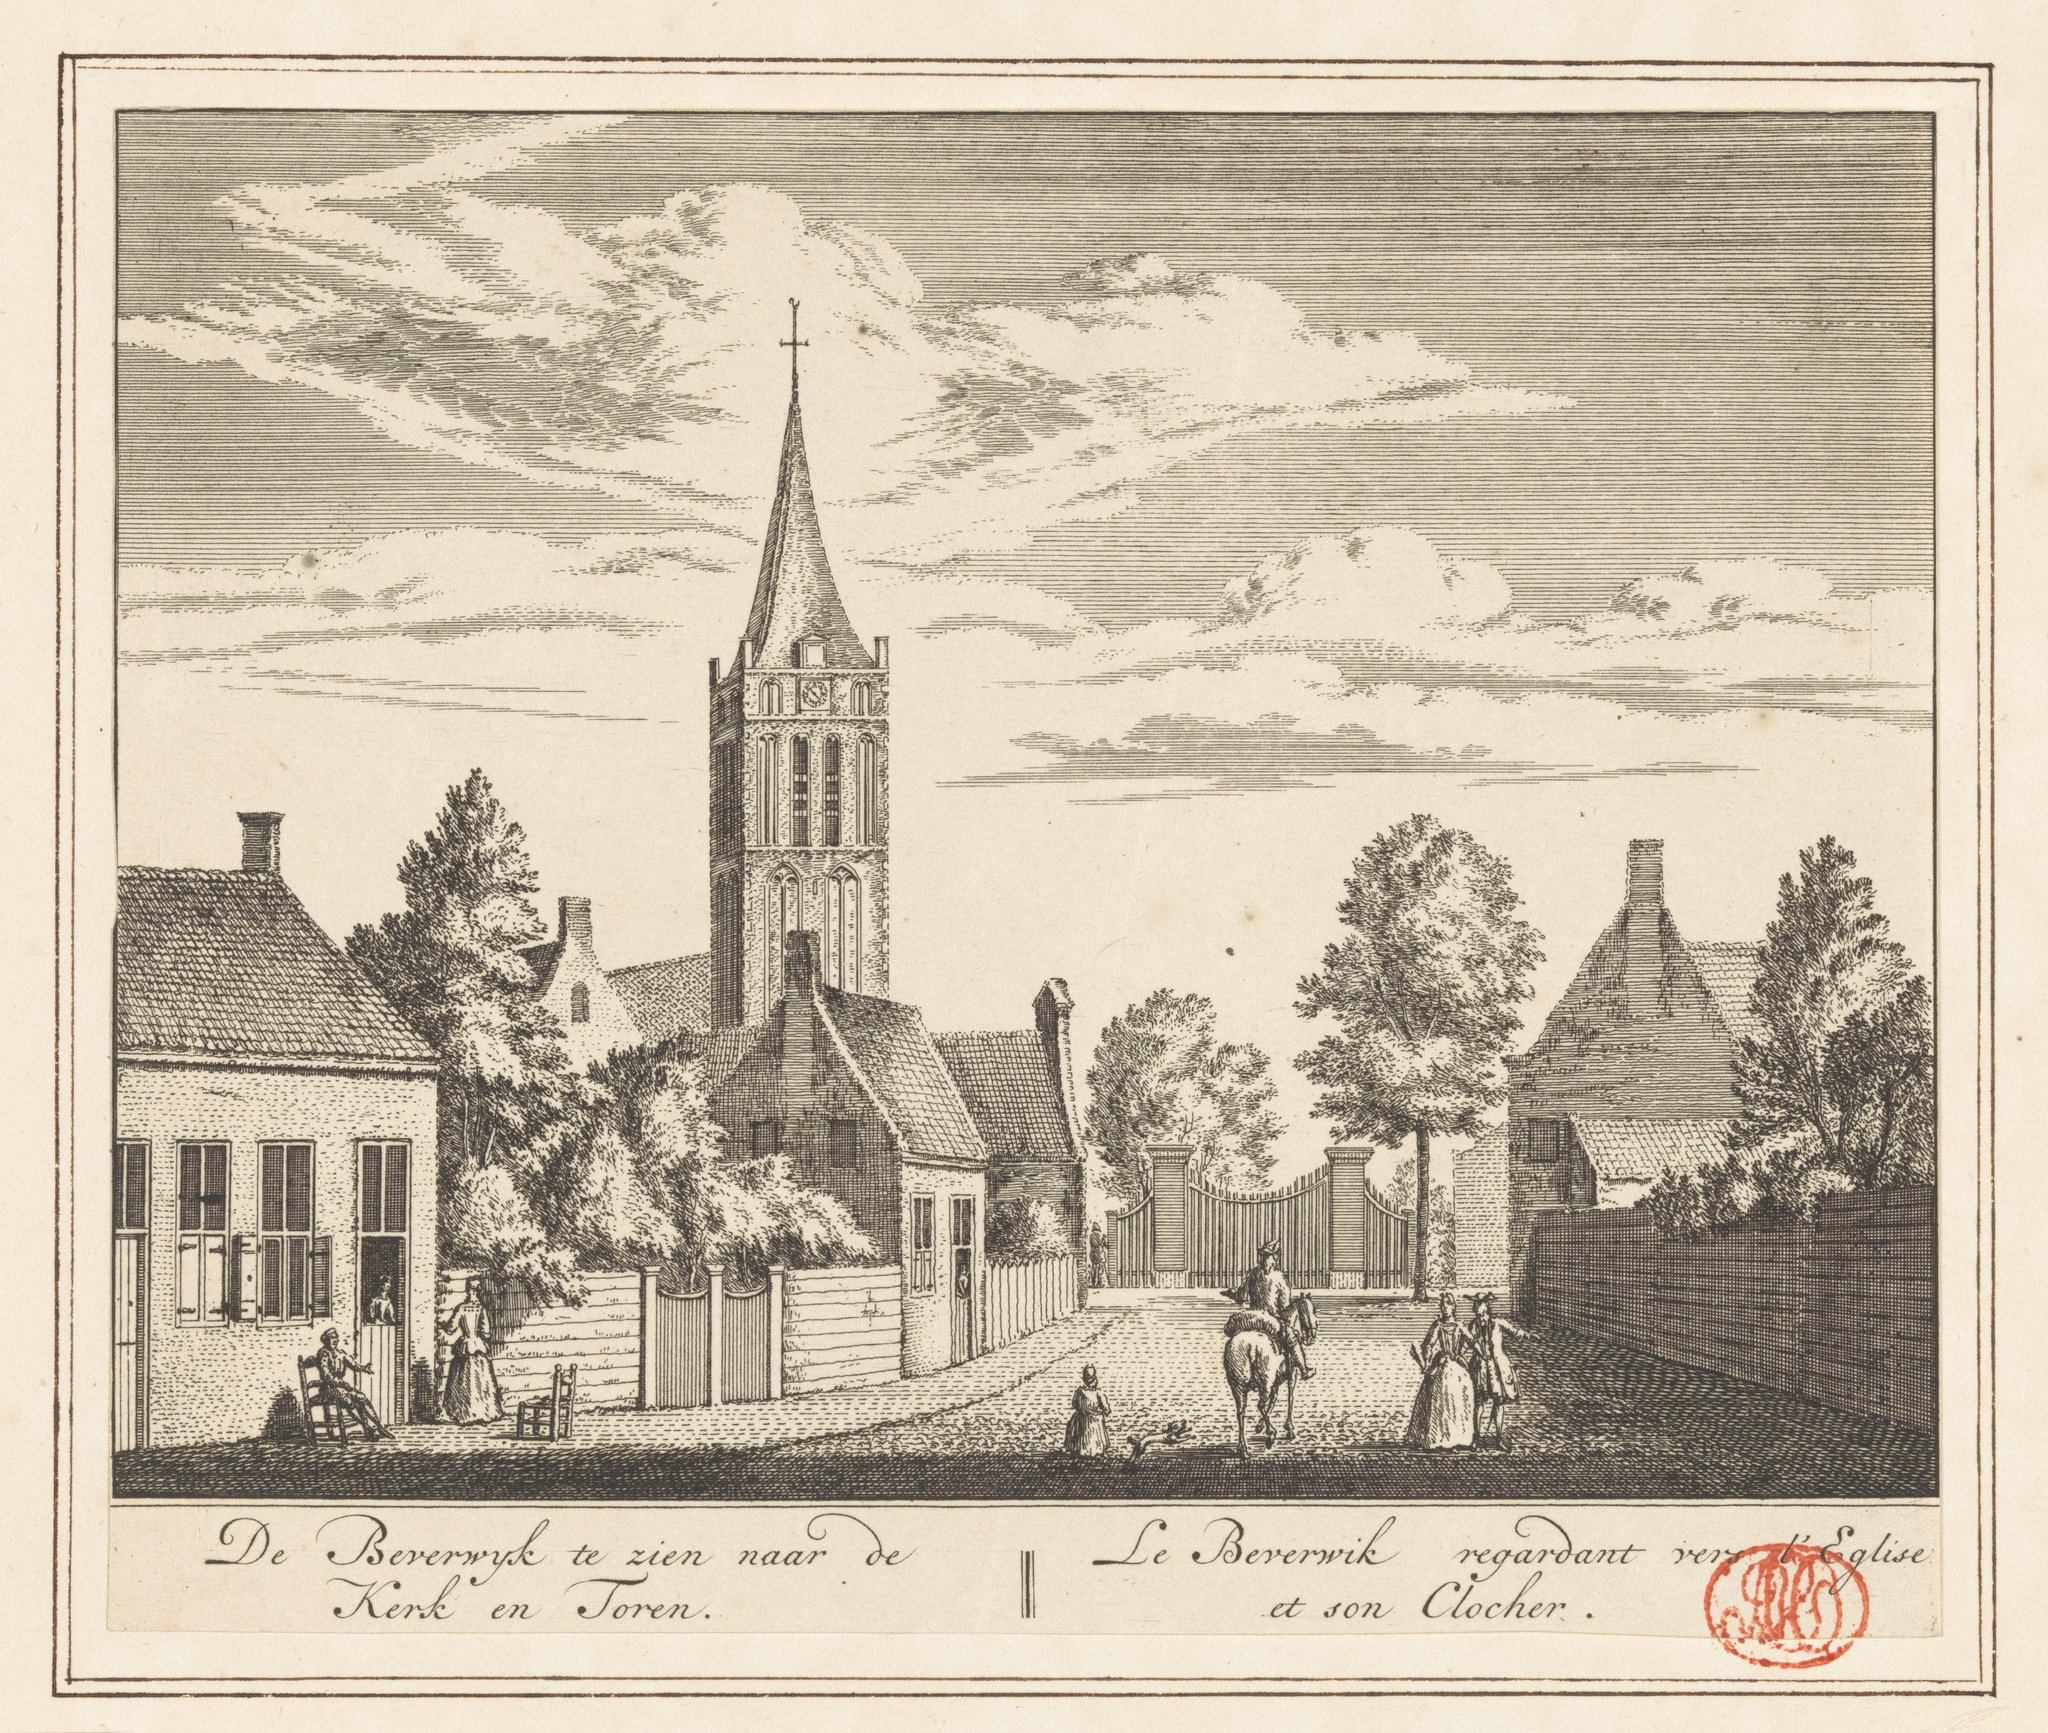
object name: print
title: Gezicht op Beverwijk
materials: paper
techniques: etching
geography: amsterdam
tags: church (exterior), prospect of city, town panorama, silhouette of city, public road (+ city(-scape) with figures, staffage)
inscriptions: collector's mark: Lugt 195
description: Prent ook gebruikt in: Rademaker, Abraham. Hollands Tempe verherelykt, vertoond in dertig uitmuntende gezigten; beginnende van Amsterdam (…) / La Hollande et tout son eclat et beauté, remontrée par trente exellentes vues, commençant d'Amsterdam (…). Amsterdam: Leonard Schenk, 1728.